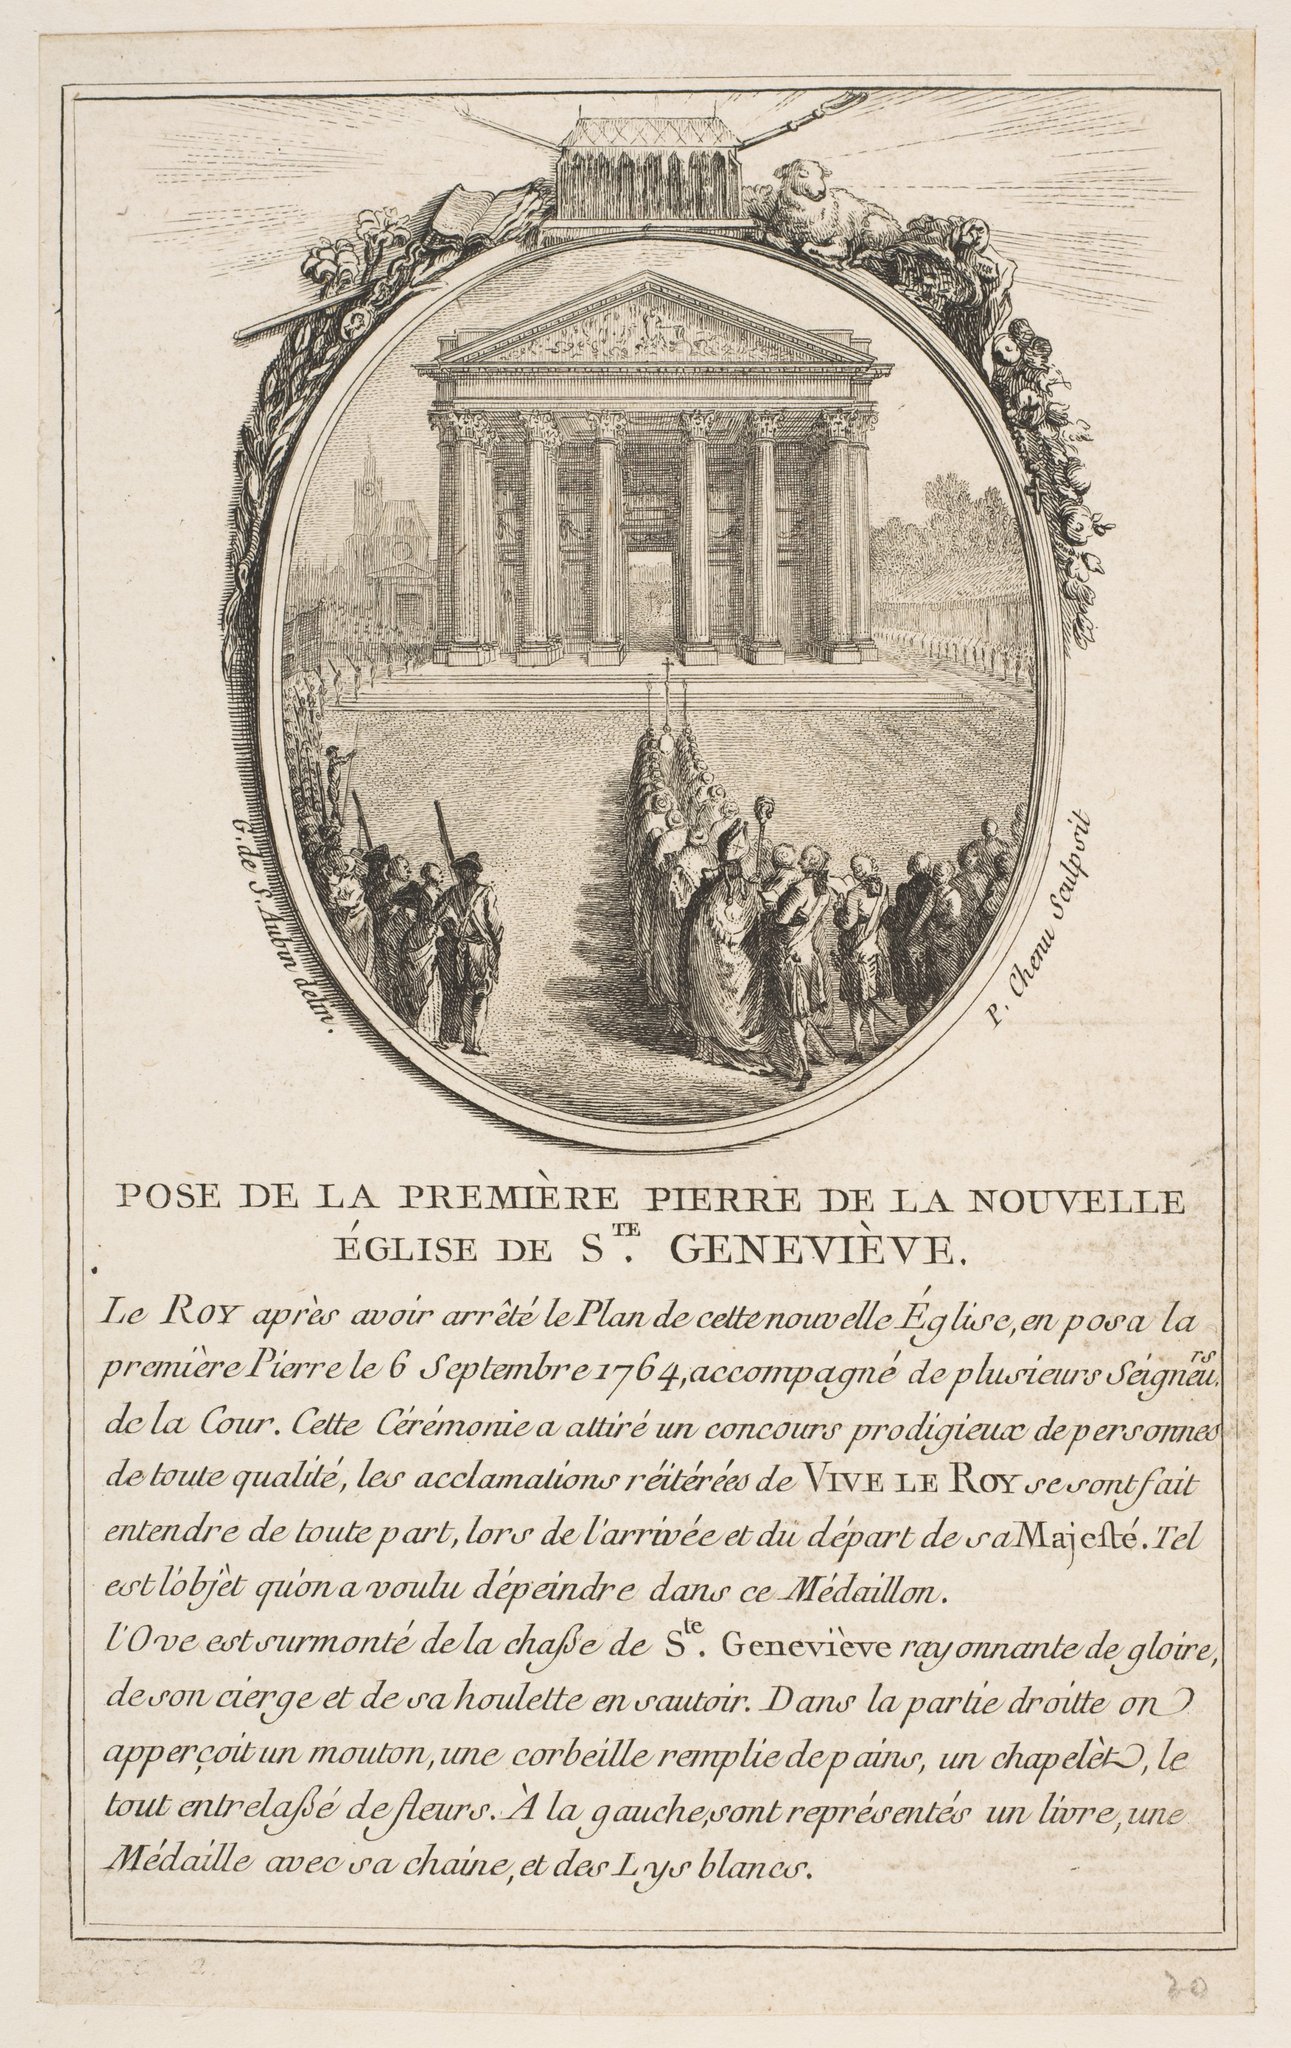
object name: print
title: Placing of the first stone for the church of Saint Genevieve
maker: gabriel de saint-aubin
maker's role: artist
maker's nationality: french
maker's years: 1724-1780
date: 1766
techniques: etching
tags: buildings